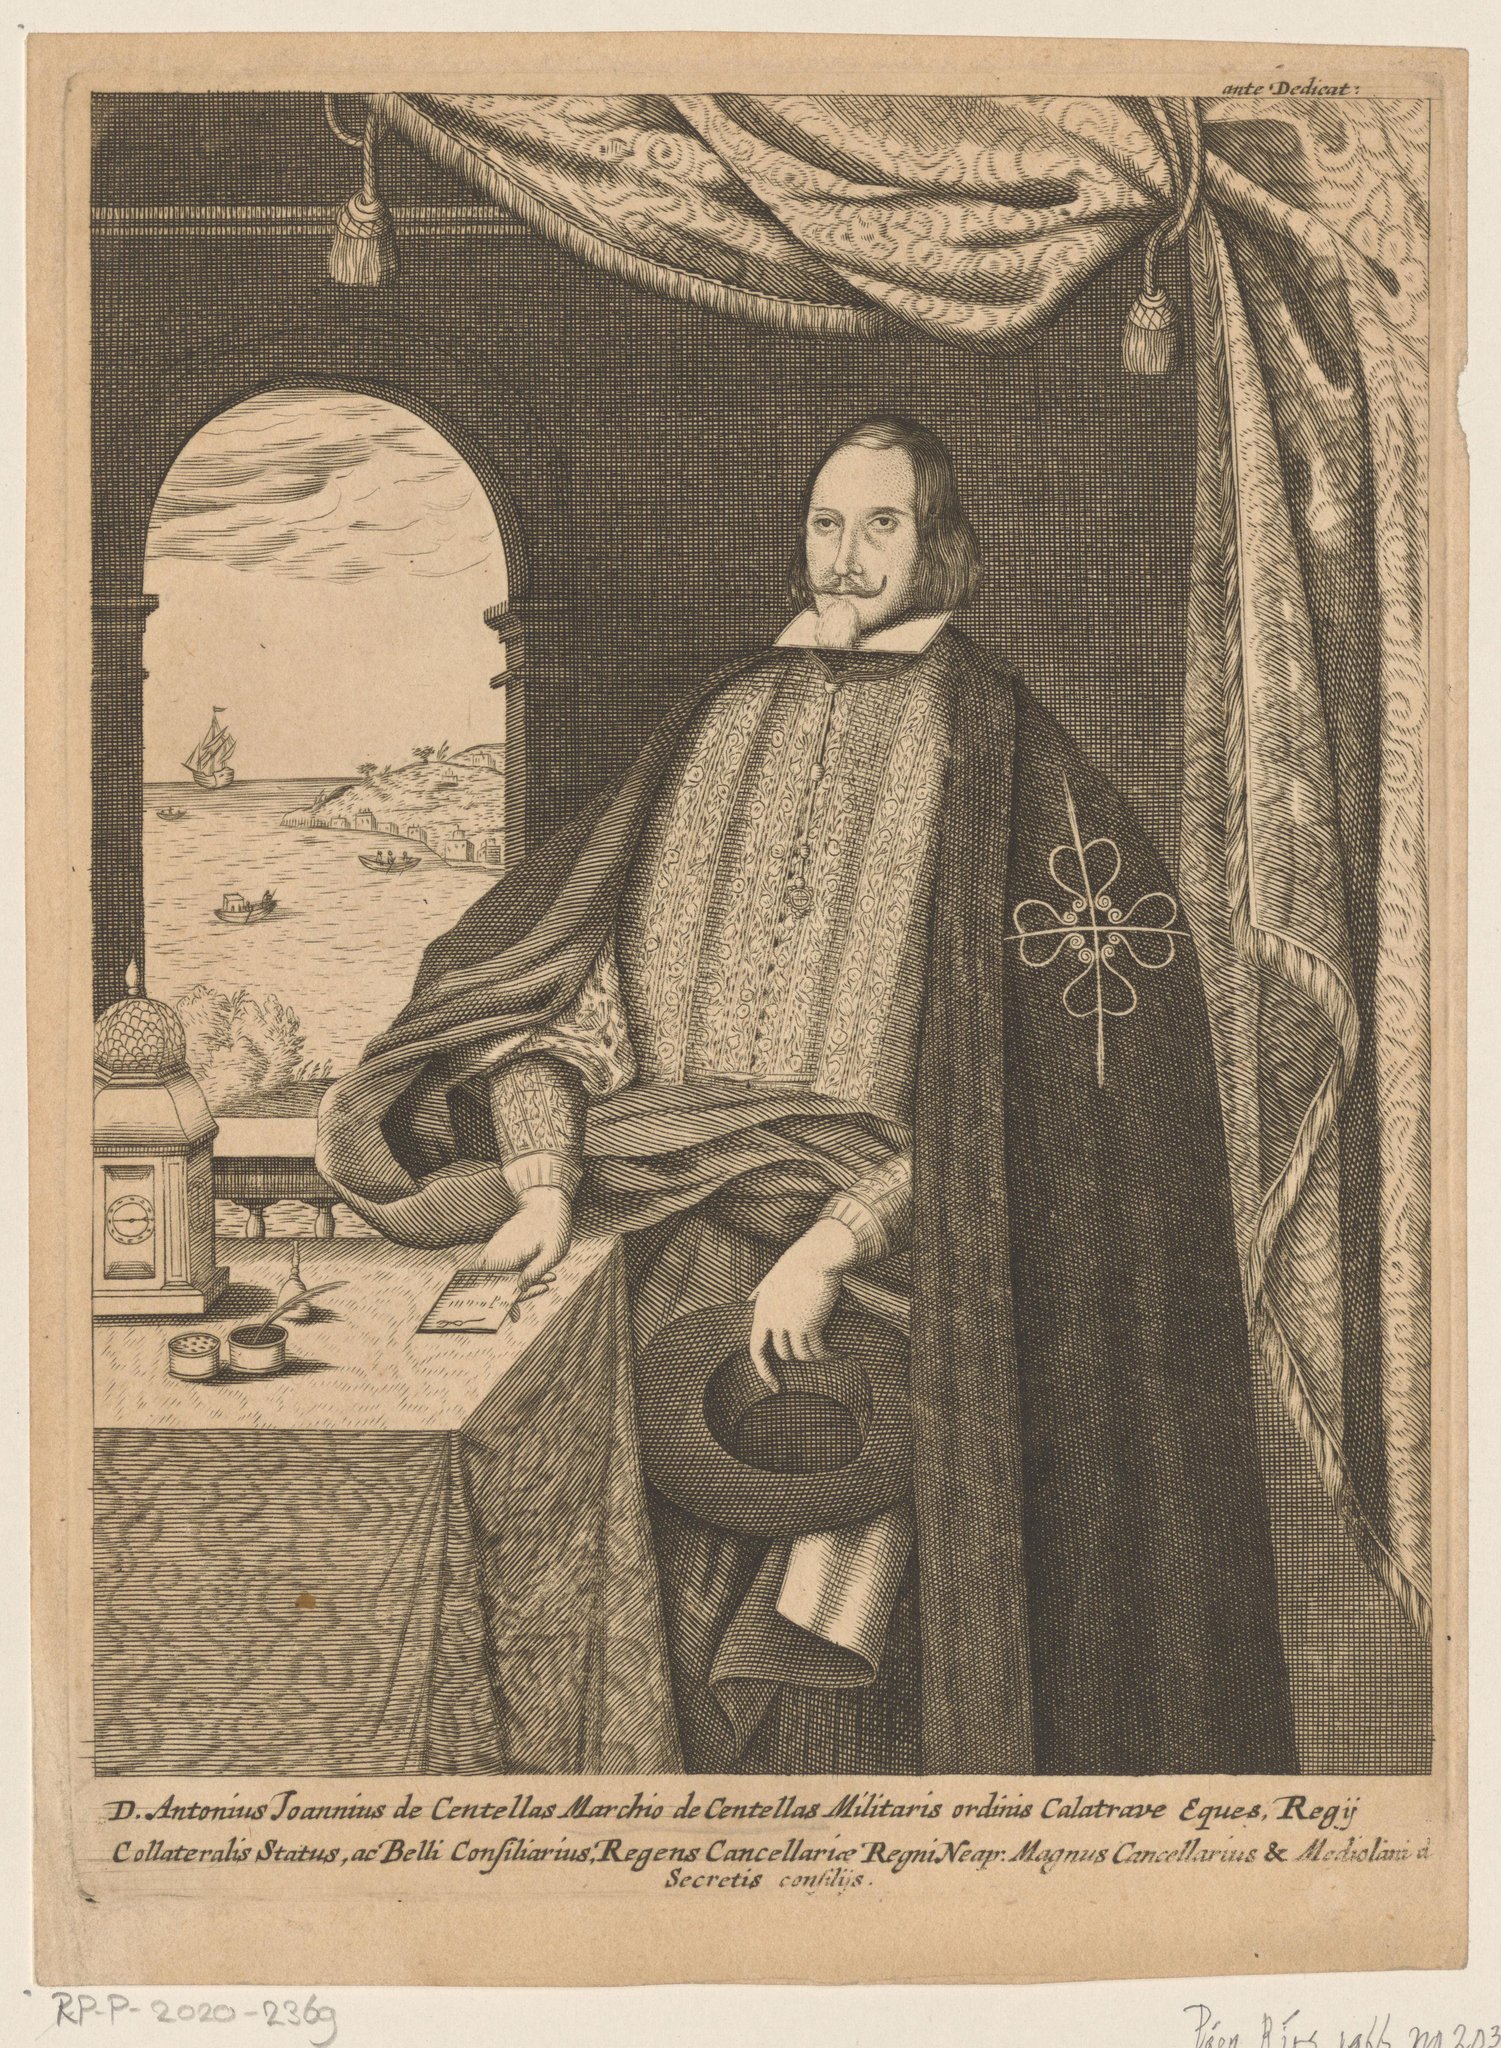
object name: print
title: Portret van Antonio Joannio de Centellas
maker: Anonymous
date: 1672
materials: paper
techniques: engraving, etching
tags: historical persons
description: Prent waarschijnlijk uit: Kircher, Athanasius. Principis christiani archetypon politicum (...). Amsterdam: Johannes Janssonius van Waesberge I, 1672.